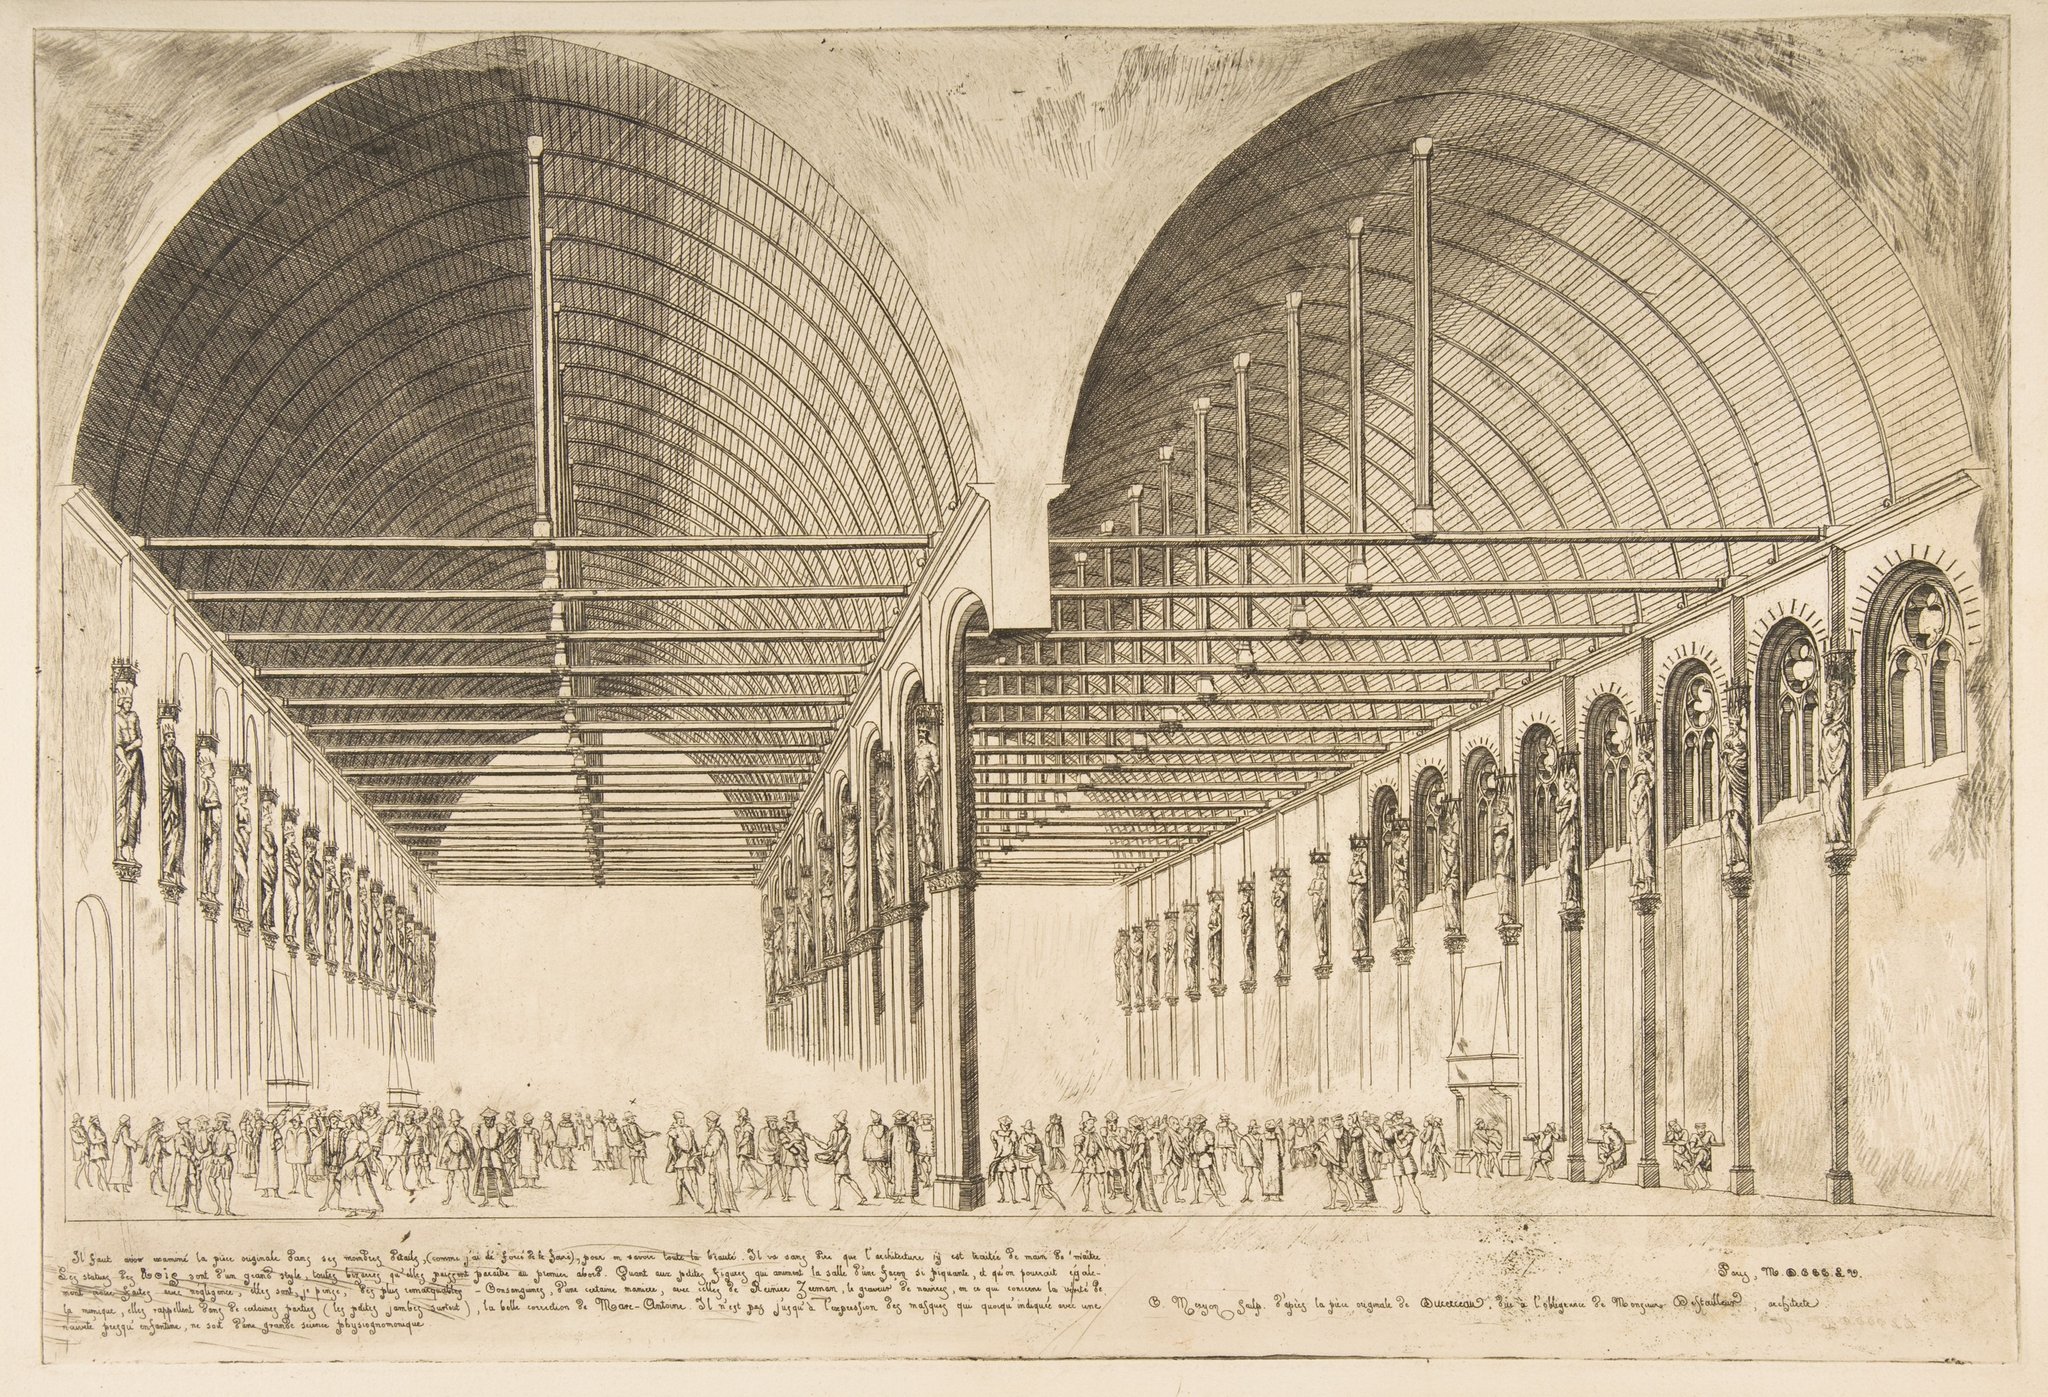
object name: print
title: La salle des pas-perdus a l'ancien Palais de Justice (The antechamber of the Palais de Justice, Paris)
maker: charles meryon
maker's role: artist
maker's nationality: french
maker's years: 1821-1868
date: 1855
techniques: etching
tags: architecture,paris